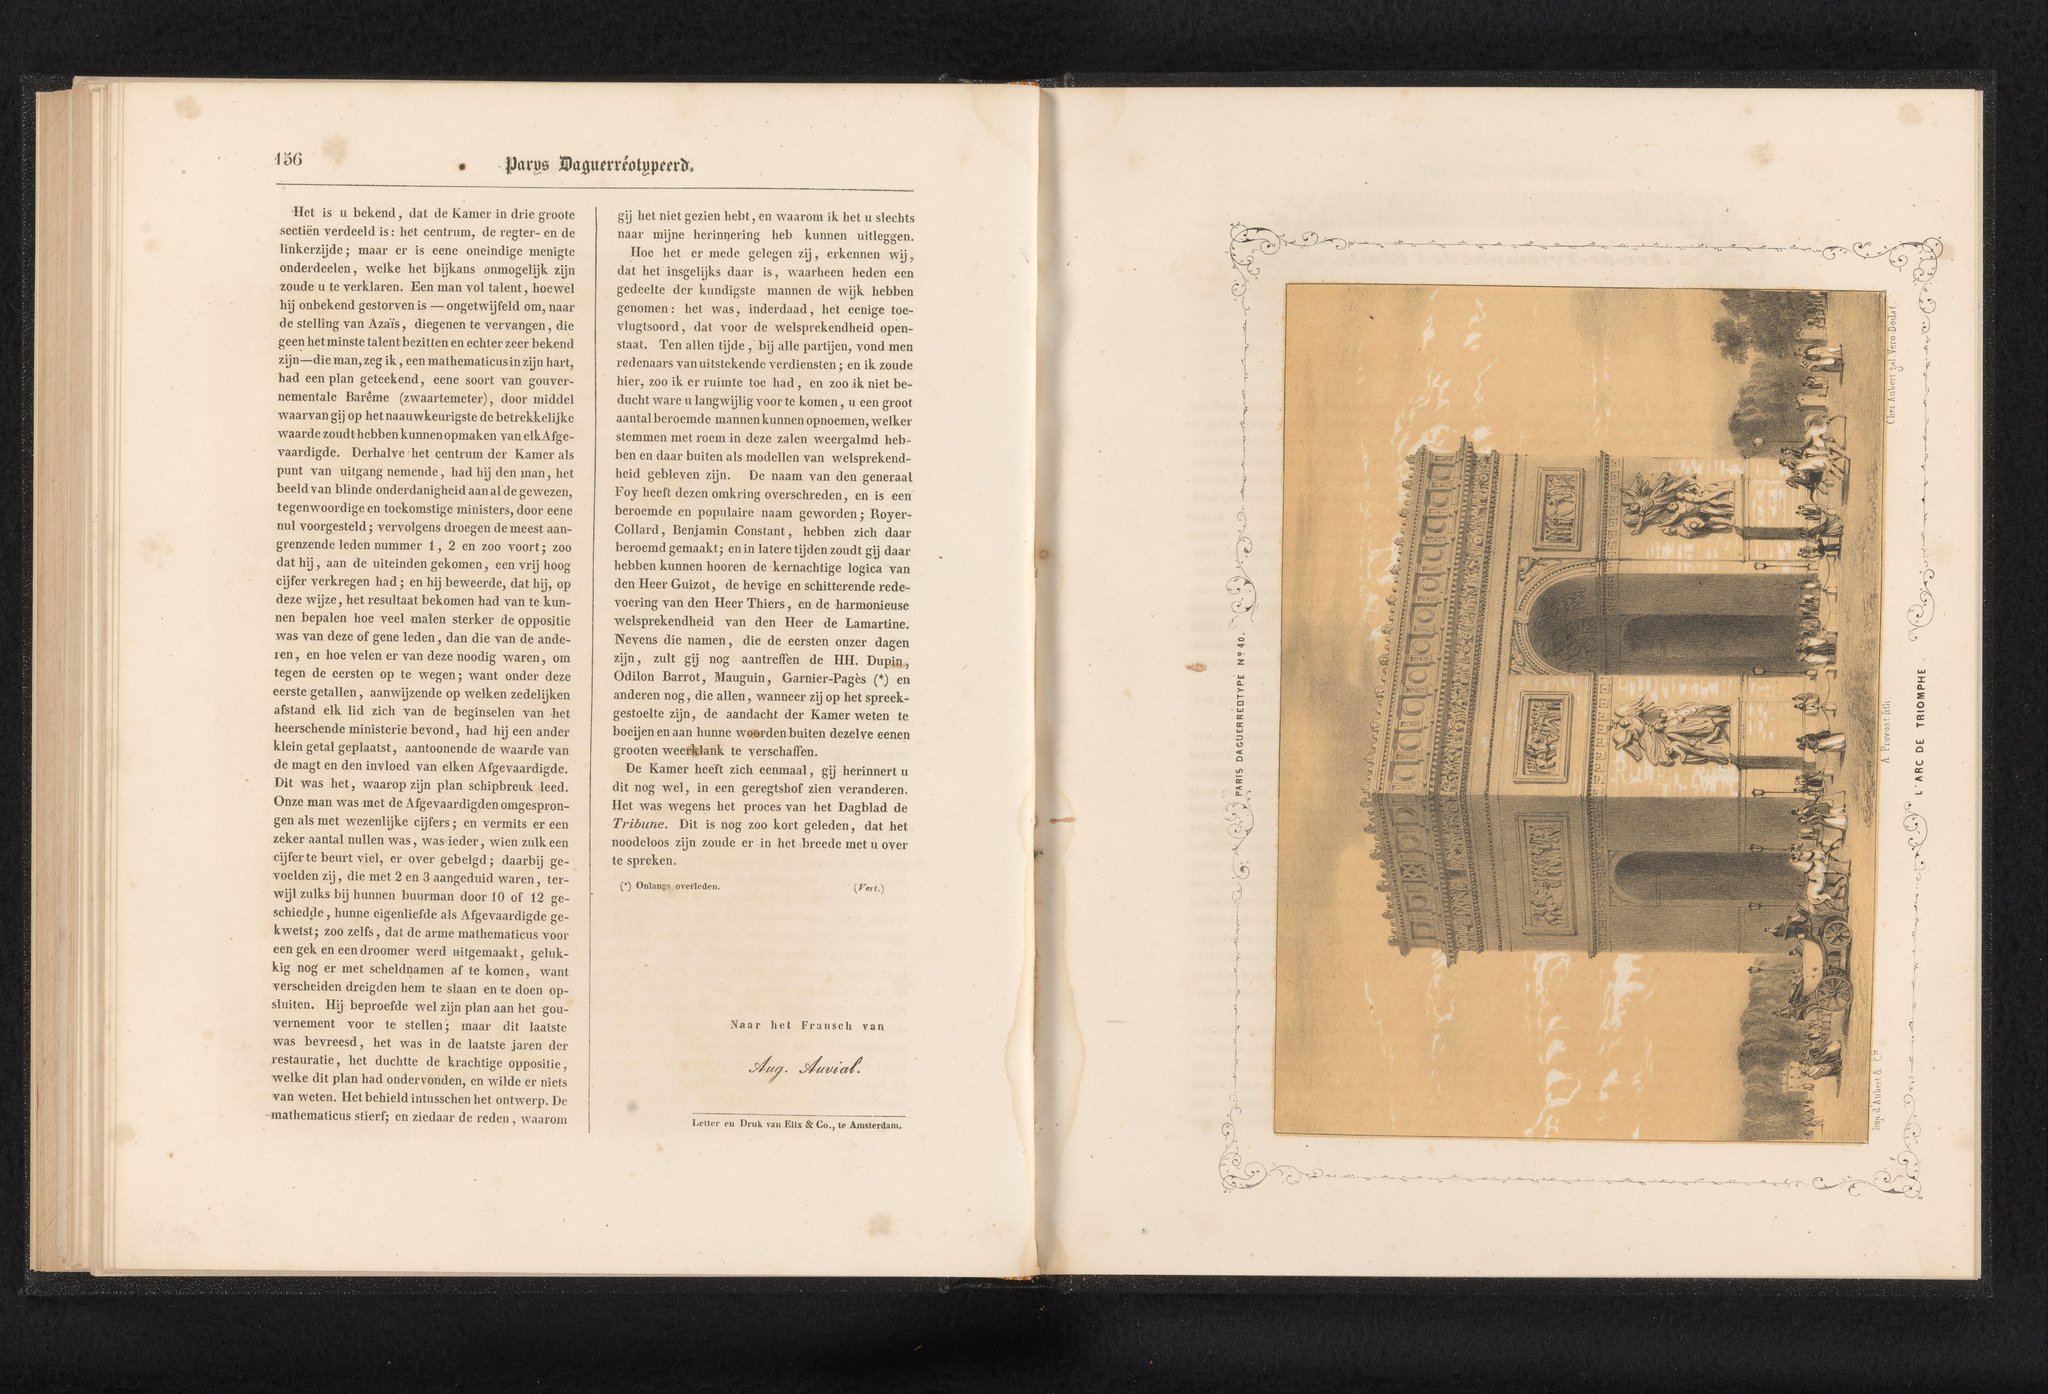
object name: page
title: Arc de Triomphe in Parijs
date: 1839-1840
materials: paper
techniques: tone lithography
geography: paris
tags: triumphal arch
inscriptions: inscription: ‘PARIS DAGUERRÉOTYPÉ No. 40.’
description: Prent op honderdnegenenvijftigste ongenummerde pagina.